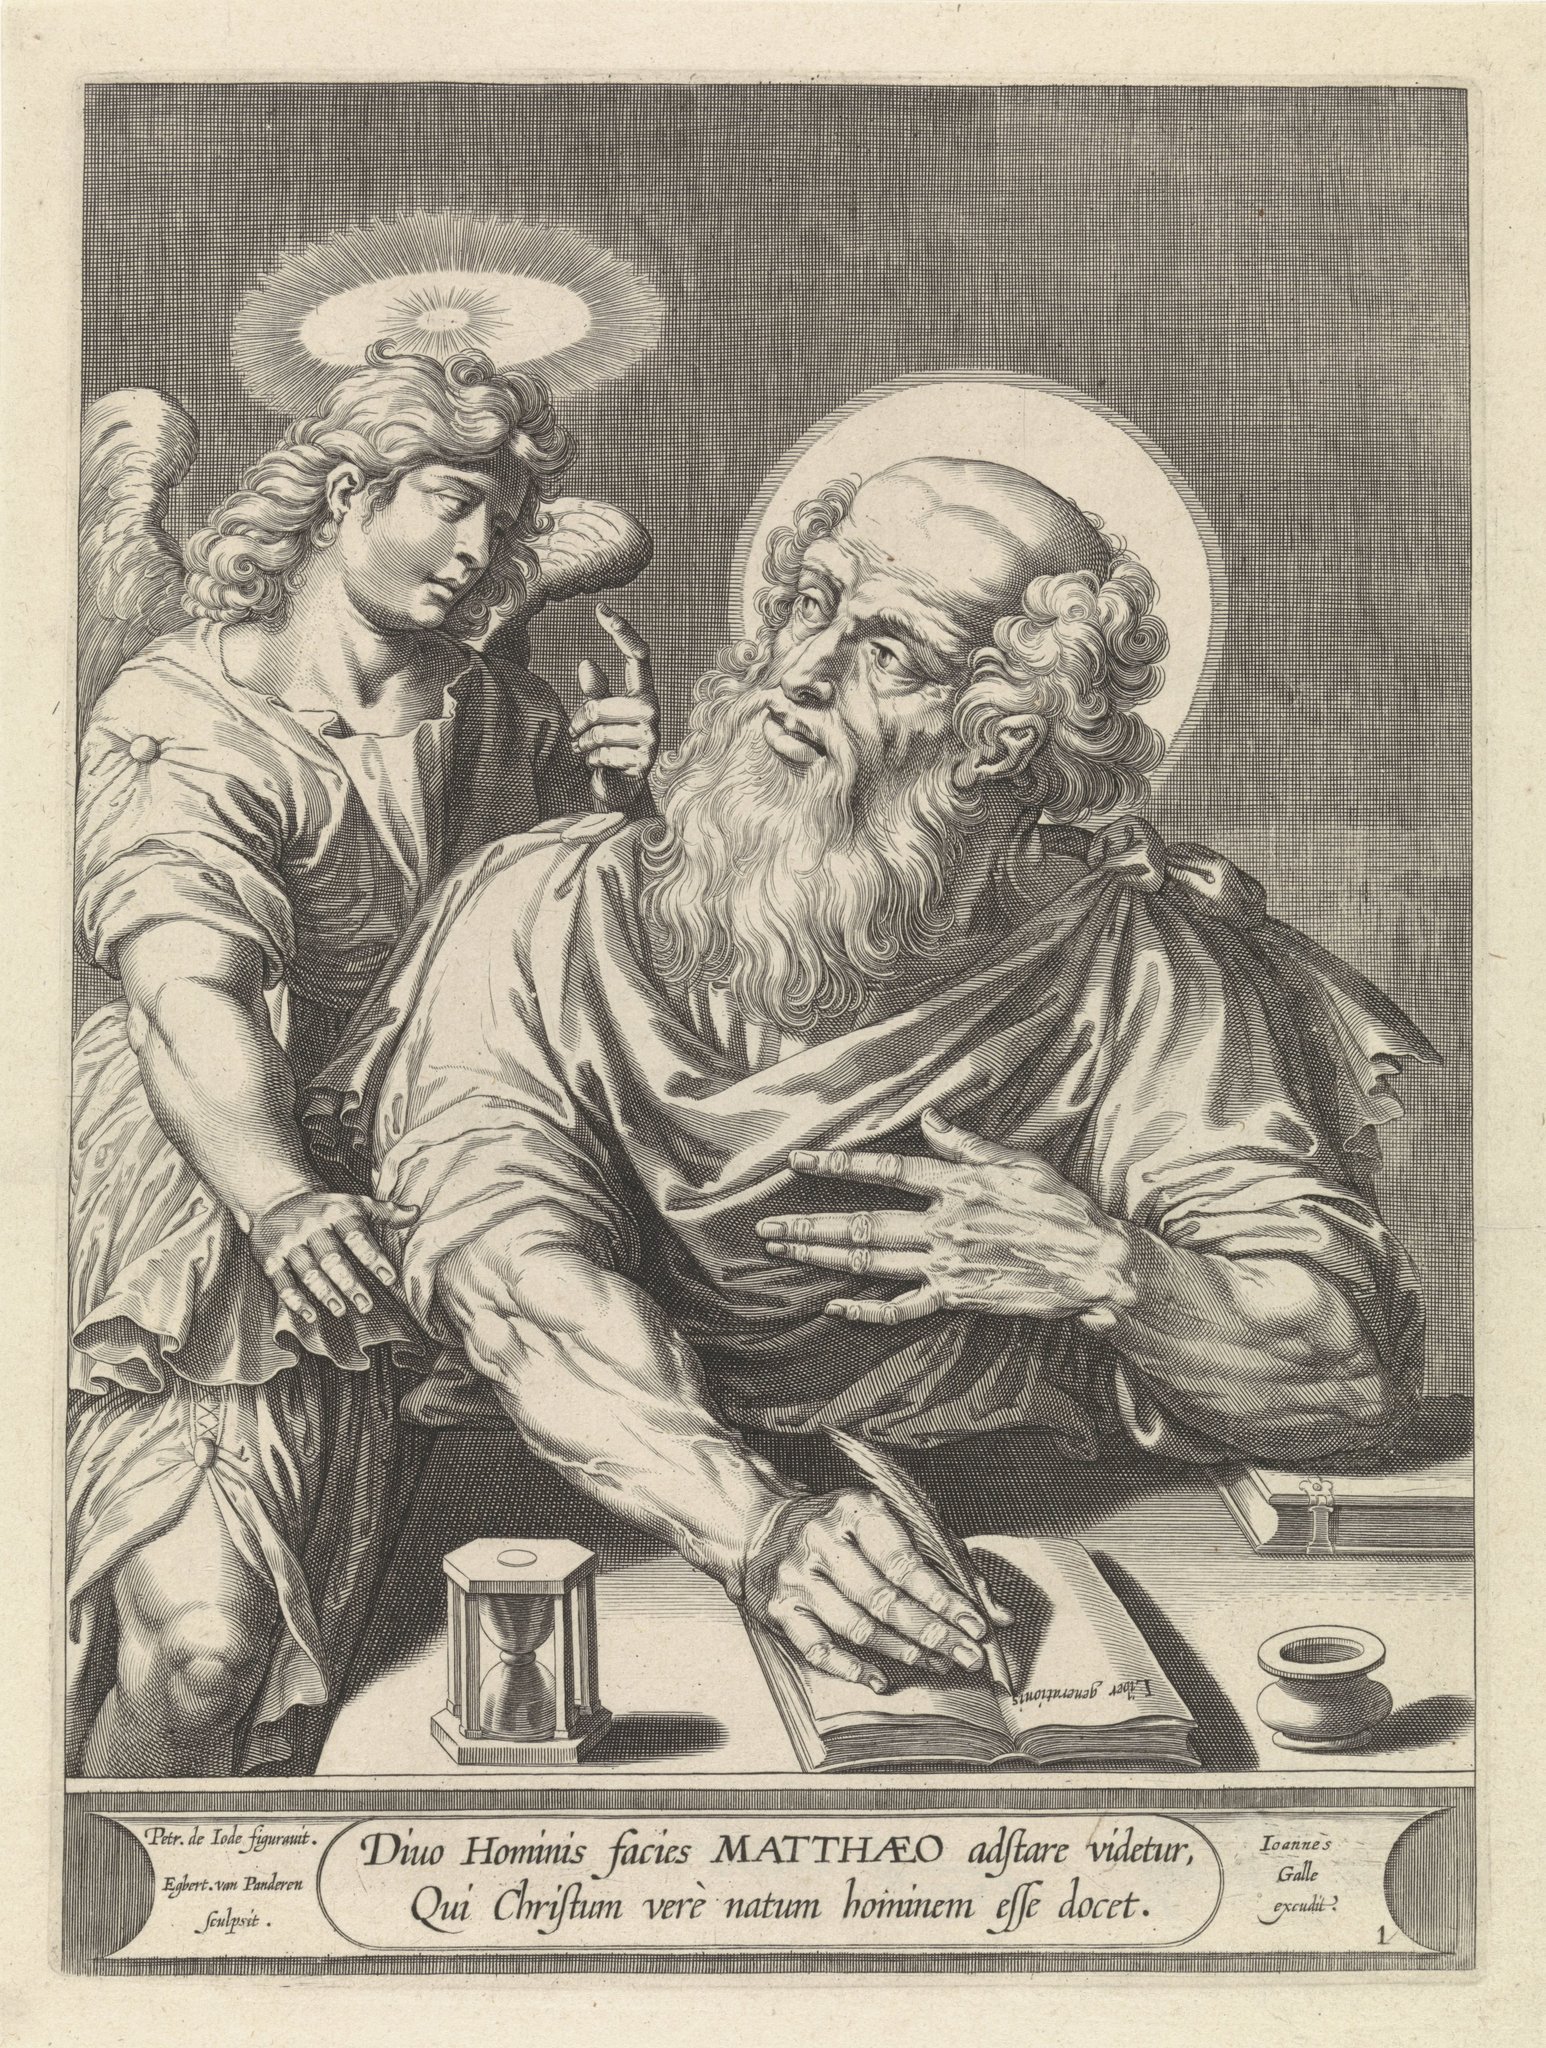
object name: print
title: Vier evangelisten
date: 1590-1637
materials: paper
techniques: engraving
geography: antwerp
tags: st. matthew writing the gospel, usually the angel present, dictating or assisting him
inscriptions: collector's mark: Lugt 2228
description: De evangelist Matteüs, schrijvend aan een tafel. Naast hem zijn attribuut de engel. In een kader een tweeregelig onderschrift in het Latijn. Eerste prent uit een serie van vier met de evangelisten.